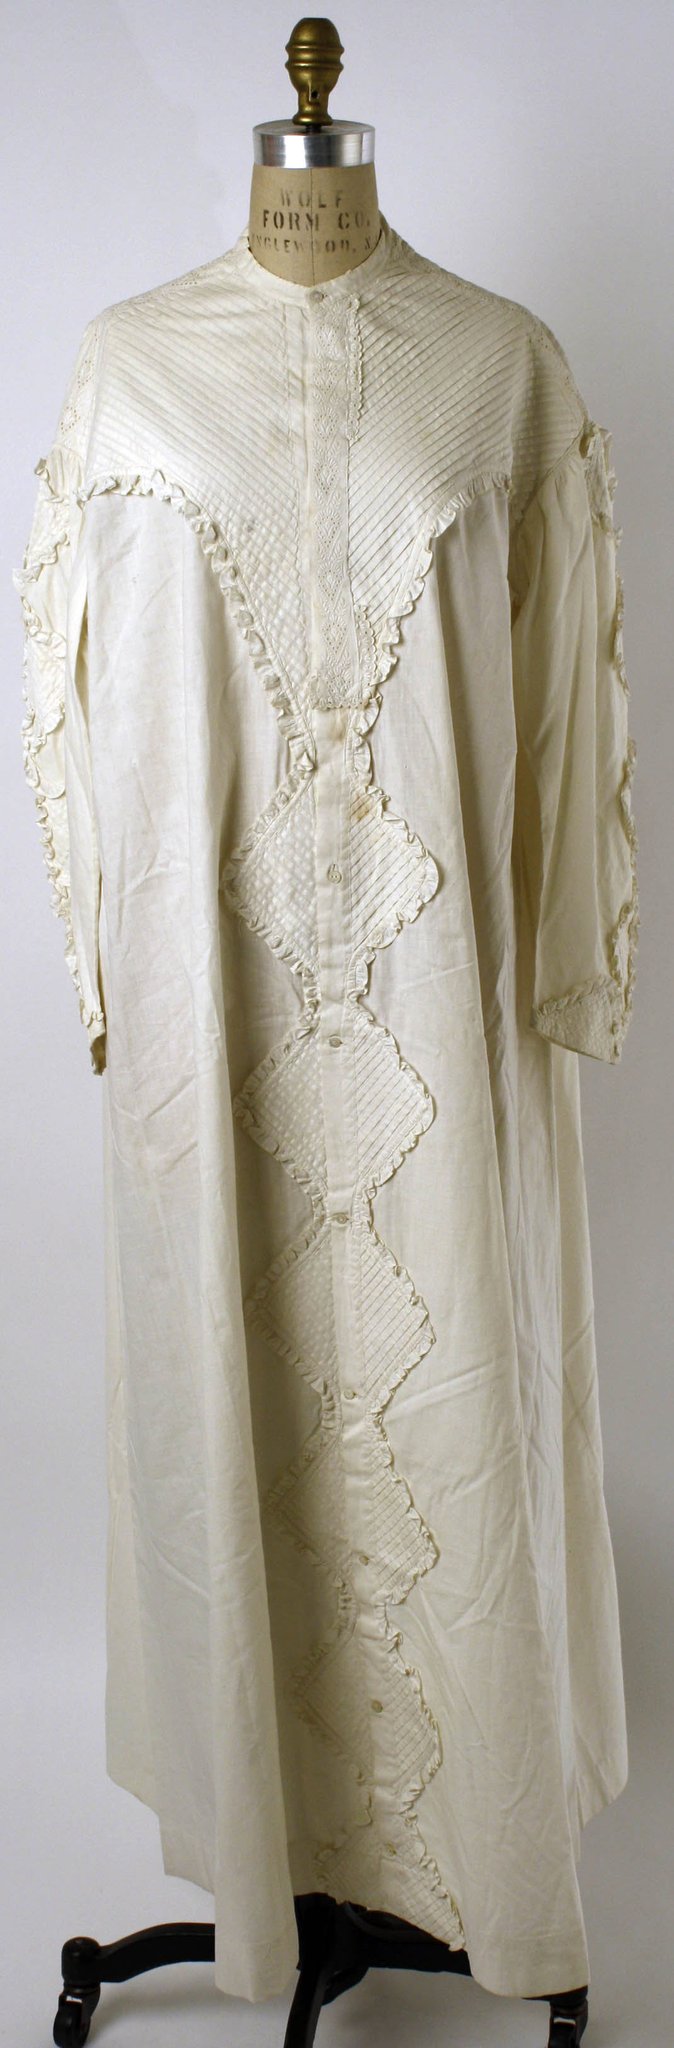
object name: nightgown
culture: american or european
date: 1860-1869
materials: cotton